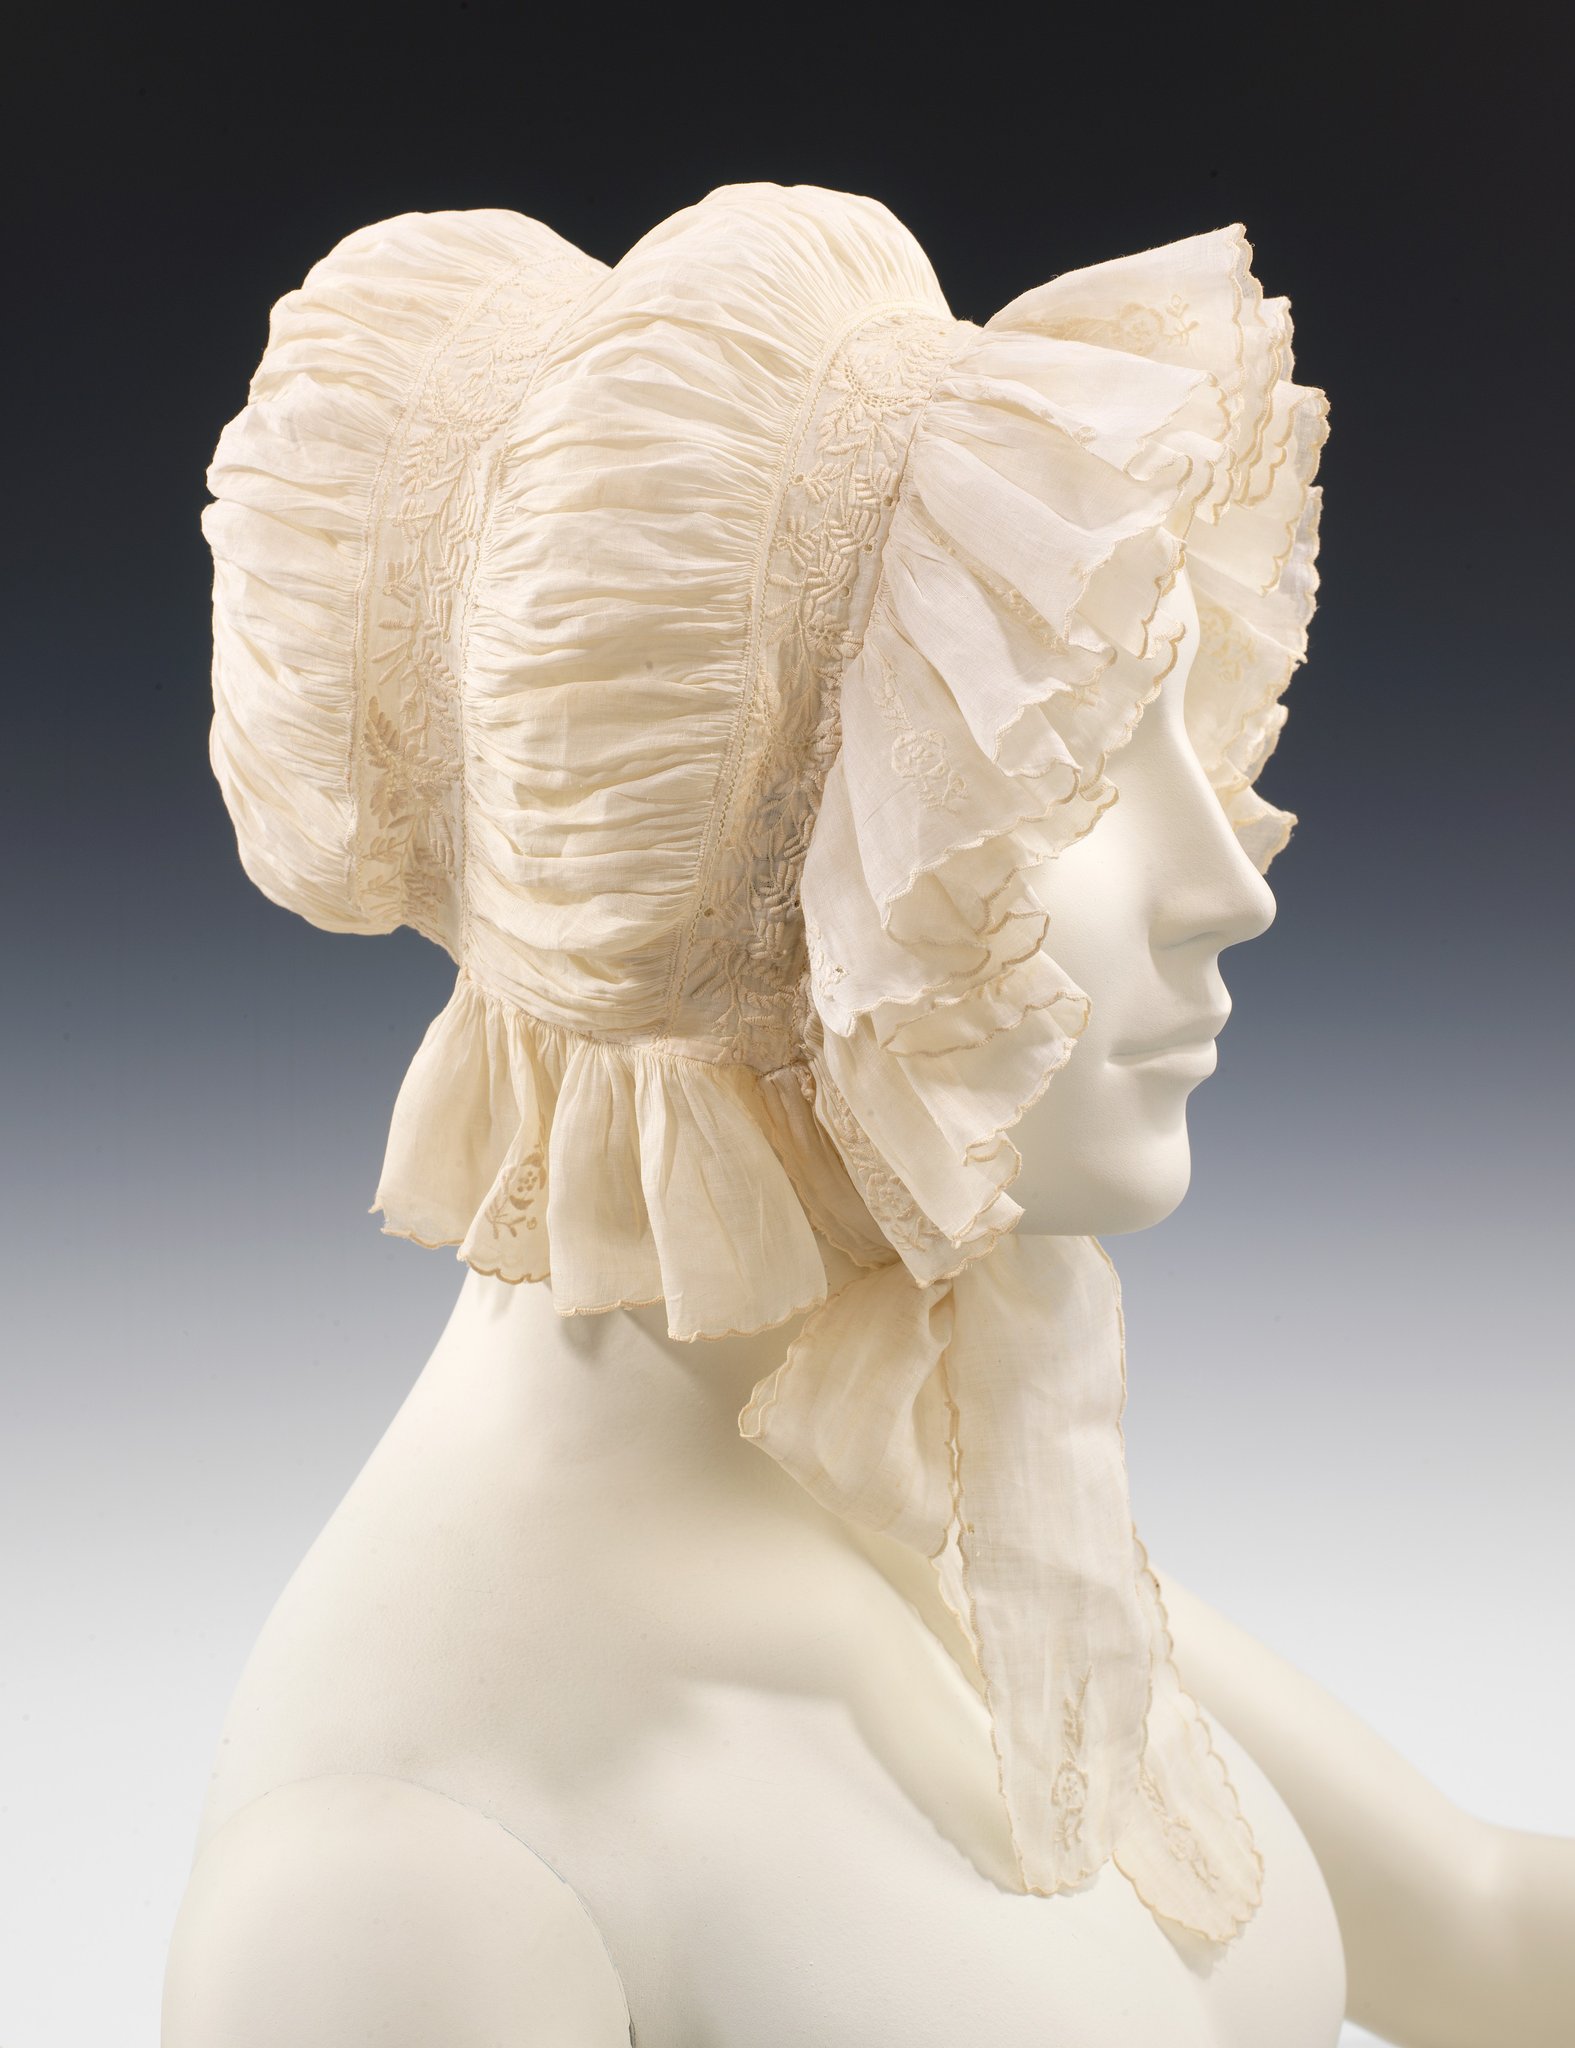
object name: morning cap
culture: american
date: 1830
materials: linen